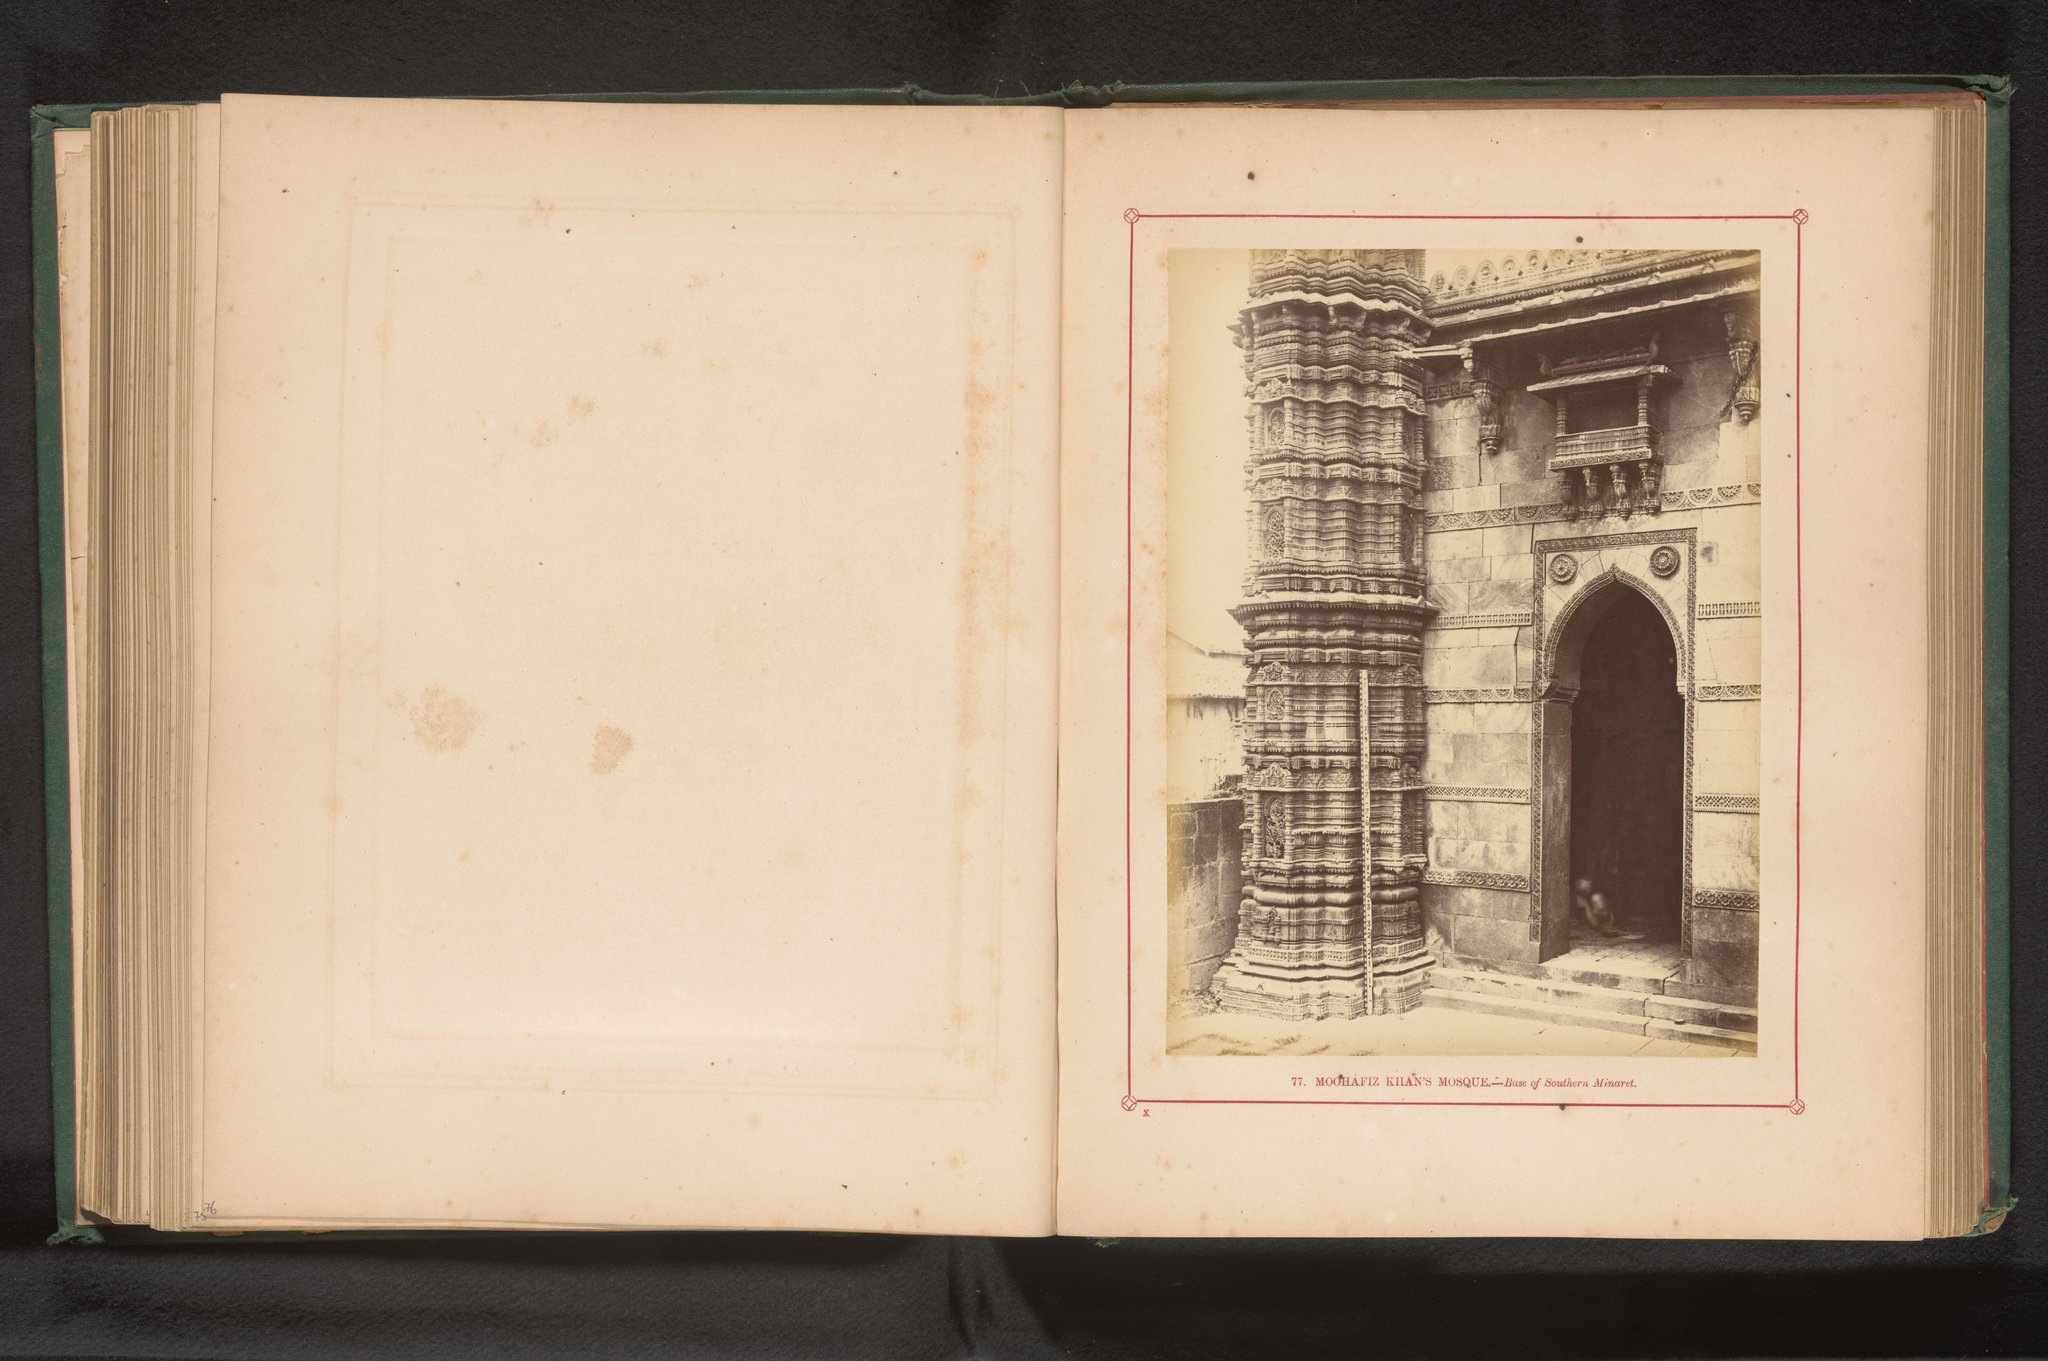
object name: photograph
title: Decoratie van het basement van een minaret van de Muhafiz Khan-moskee in Ahmedabad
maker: thomas biggs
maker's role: fotograaf, kapitein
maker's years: 1822-1905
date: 1856-1866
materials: photographic support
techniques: albumen print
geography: ahmedabad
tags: temple, shrine ~ islam, mohammedanism, base (~ column, pillar)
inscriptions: inscription: ‘X’, number: ‘77.’